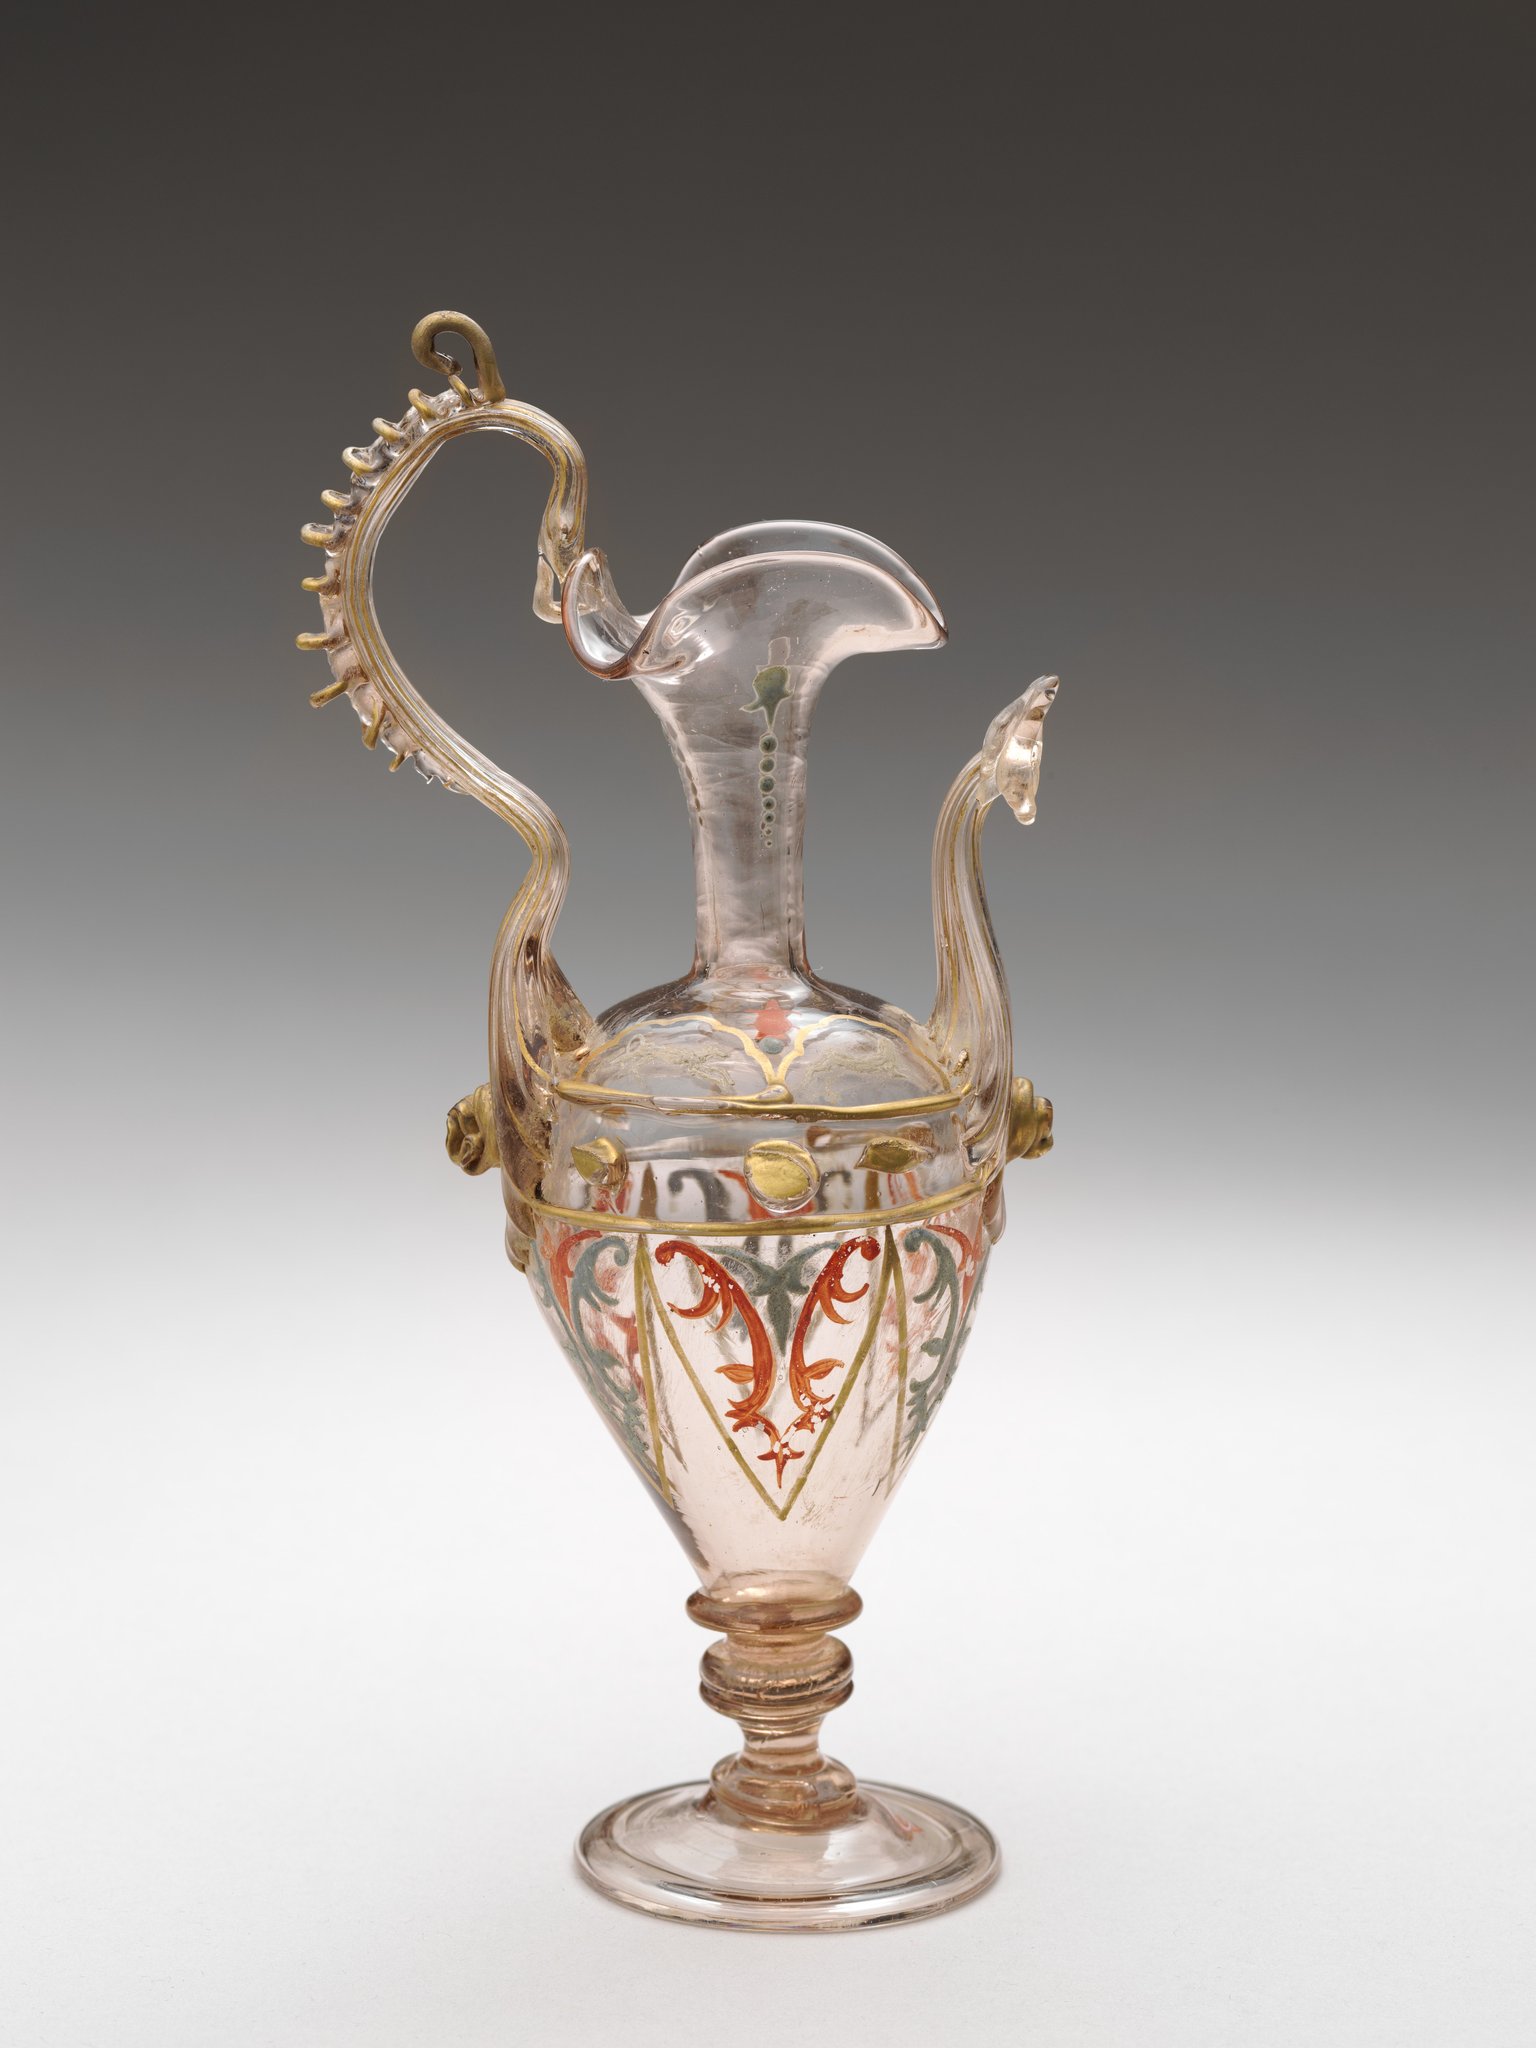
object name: ewer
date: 1801-1900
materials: glass